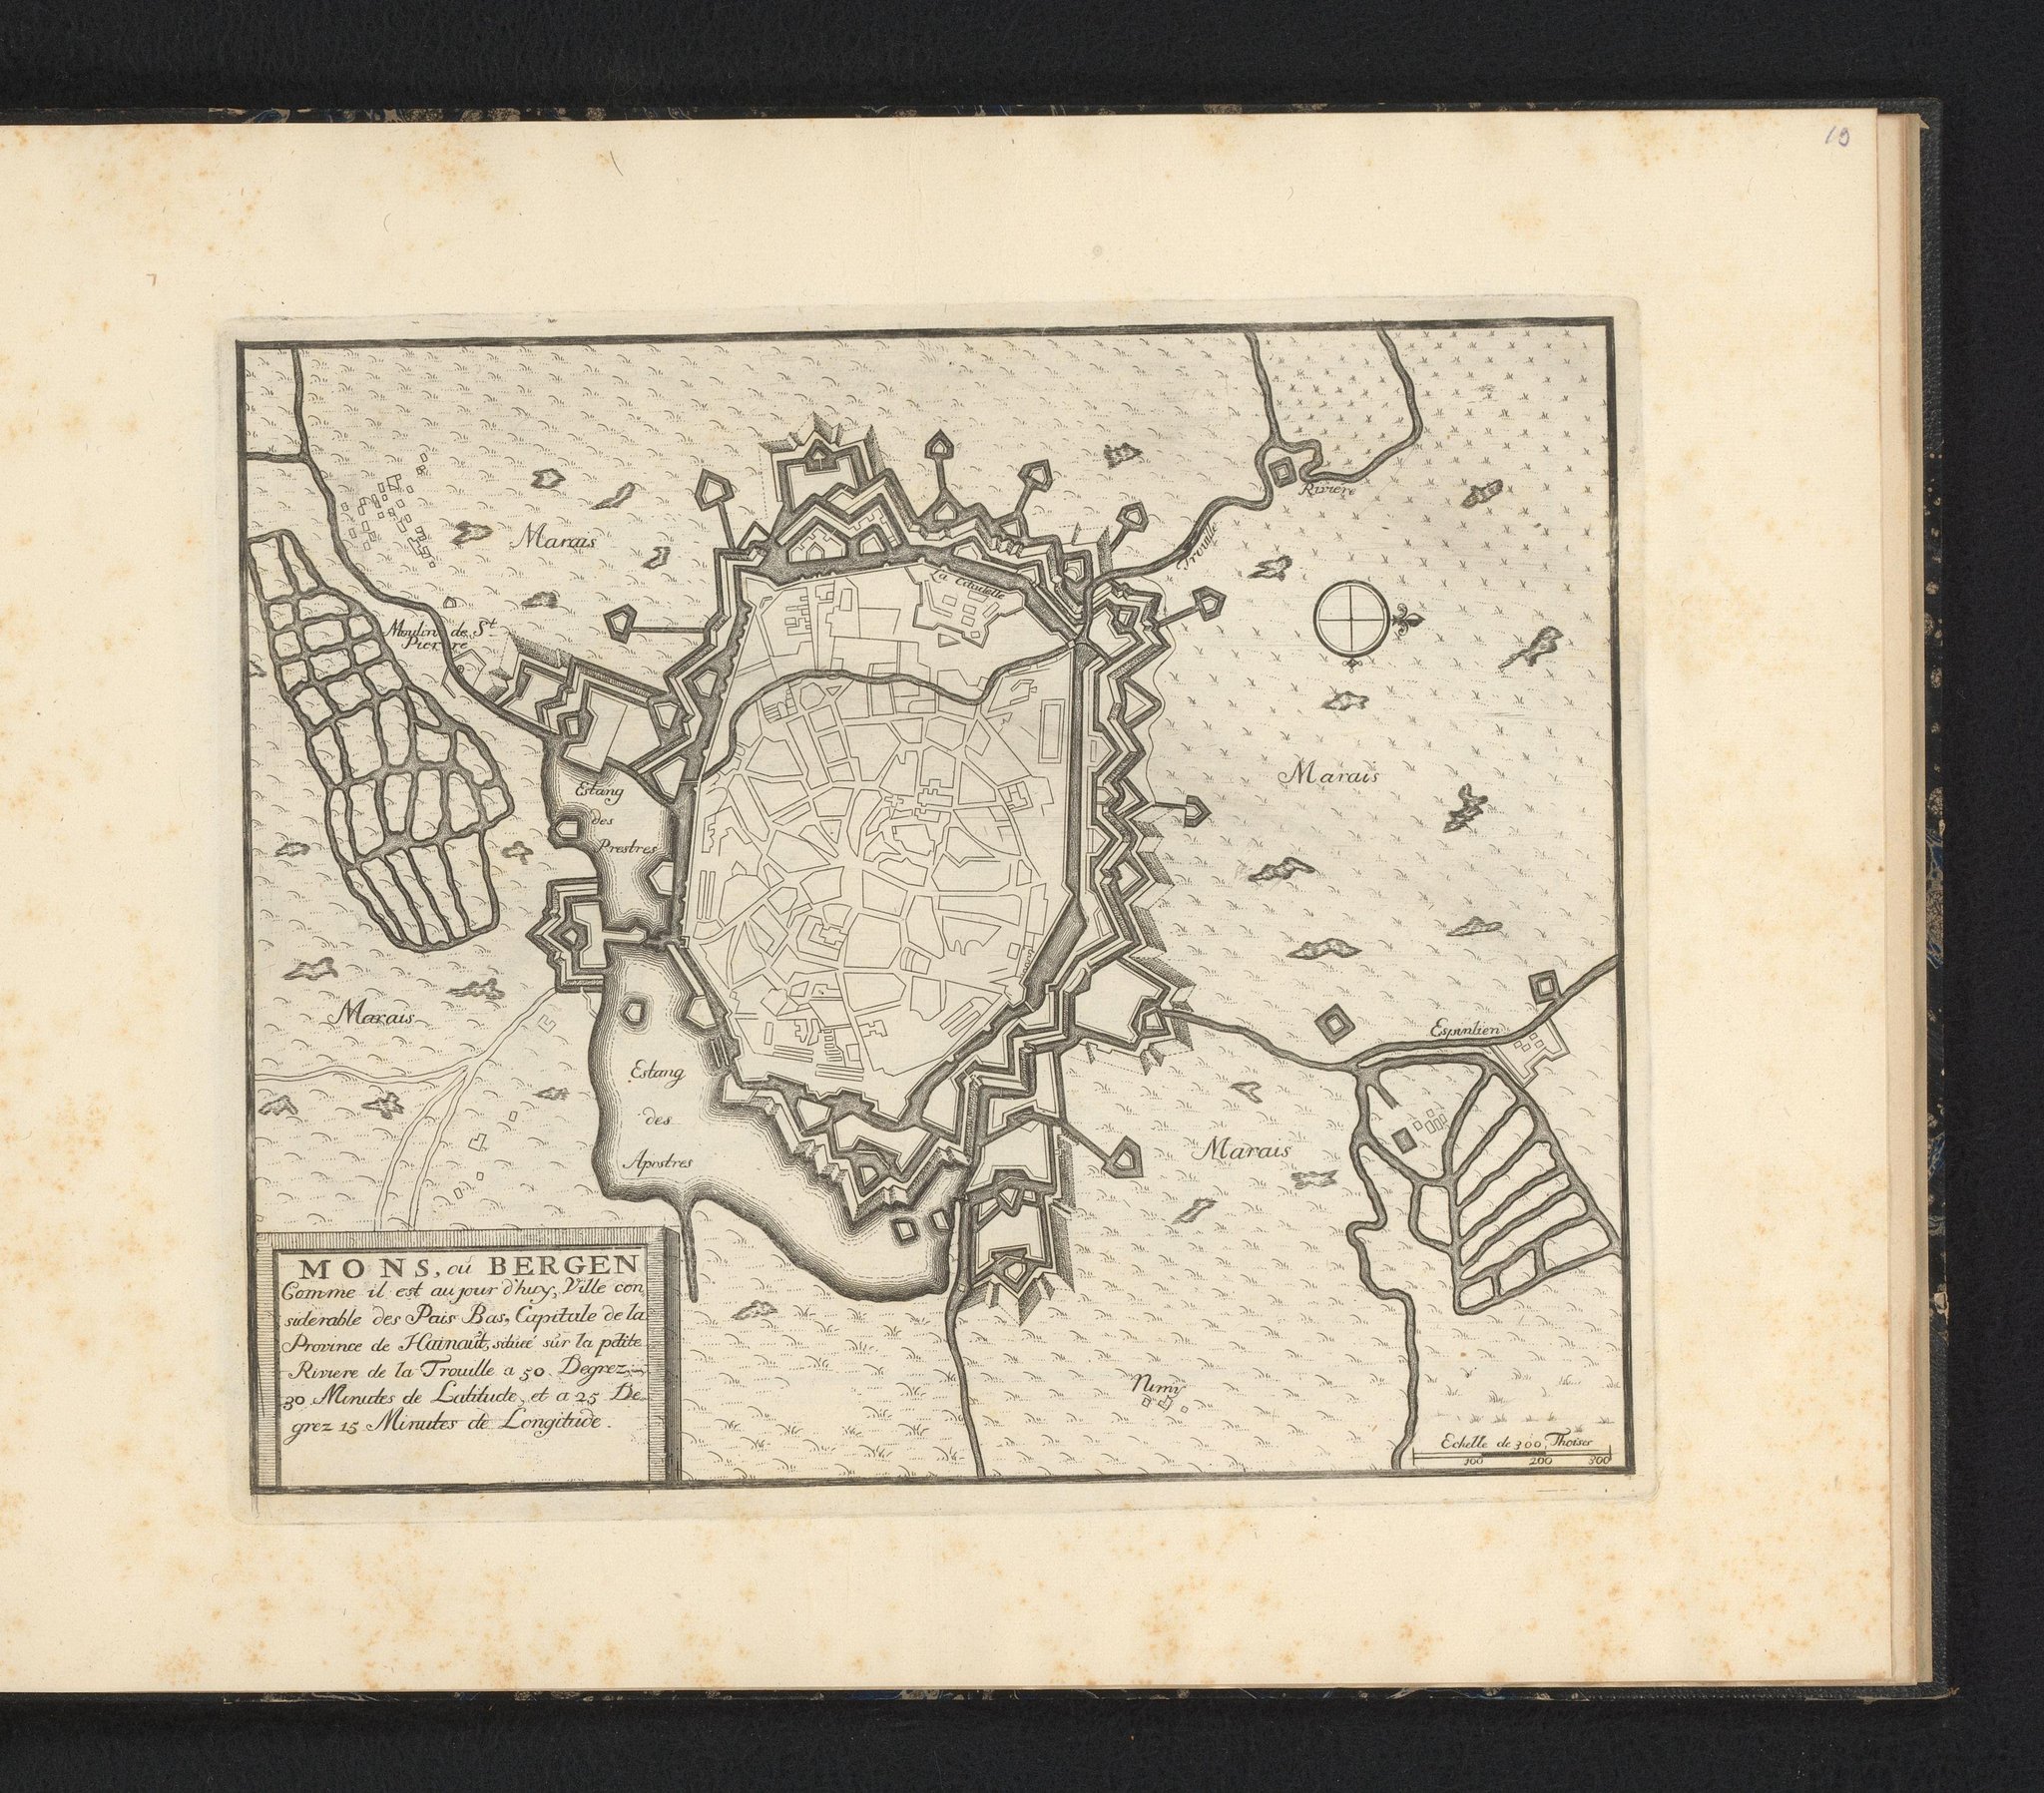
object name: print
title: Mons, ou Bergen Comme il est au jour d'huy. Ville Considerable des Pais Bas (...)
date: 1693-1696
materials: paper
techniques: etching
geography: france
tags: fortress, maps of cities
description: Plattegrond van de versterkingen van de stad Mons (Bergen) in de graafschap Henegouwen. Maakt deel uit van het eerste deel van het prentwerk: Le Theatre de la Guerre, dans les Pays-Bas, uitgegeven in 1696. Dit deel bevat 25 platen met plannen (afkomstig van Sébastien Le Prestre, Seigneur de Vauban) van vermaarde sterke steden en vestingen in de Negenjarige Oorlog in de Nederlanden. Titel en opschriften in het Frans.